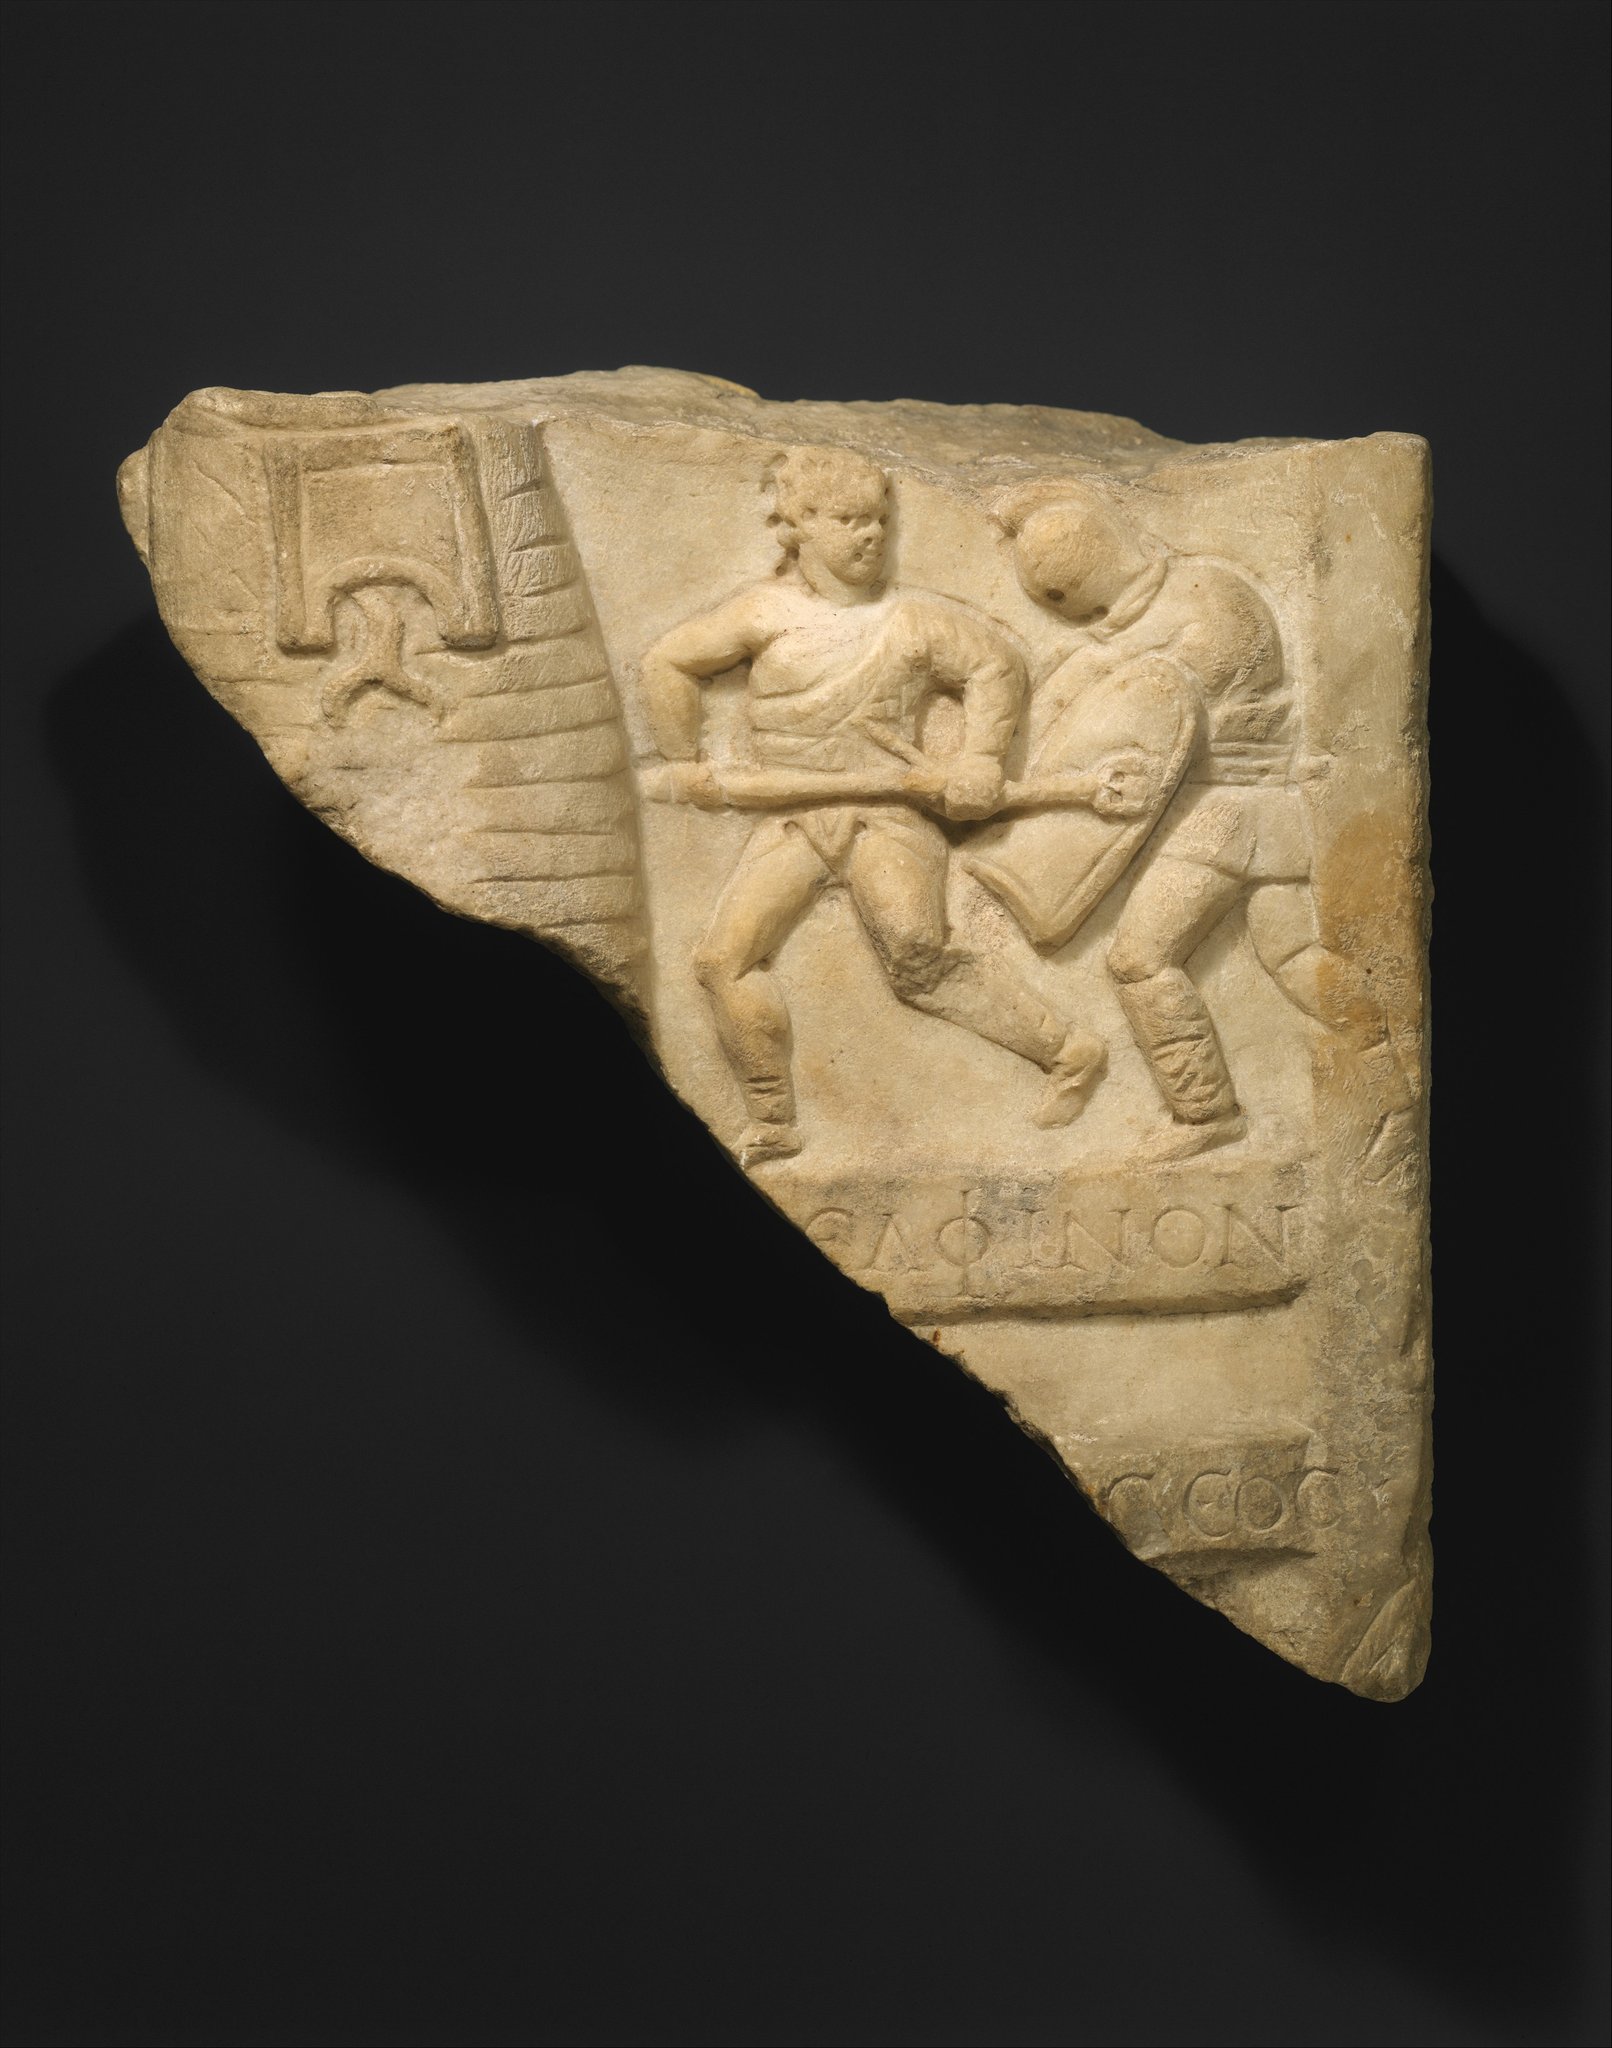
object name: relief fragment with secutor and retiarius in arena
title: Marble relief fragment with gladiators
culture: roman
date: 1-300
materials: marble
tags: shields,men